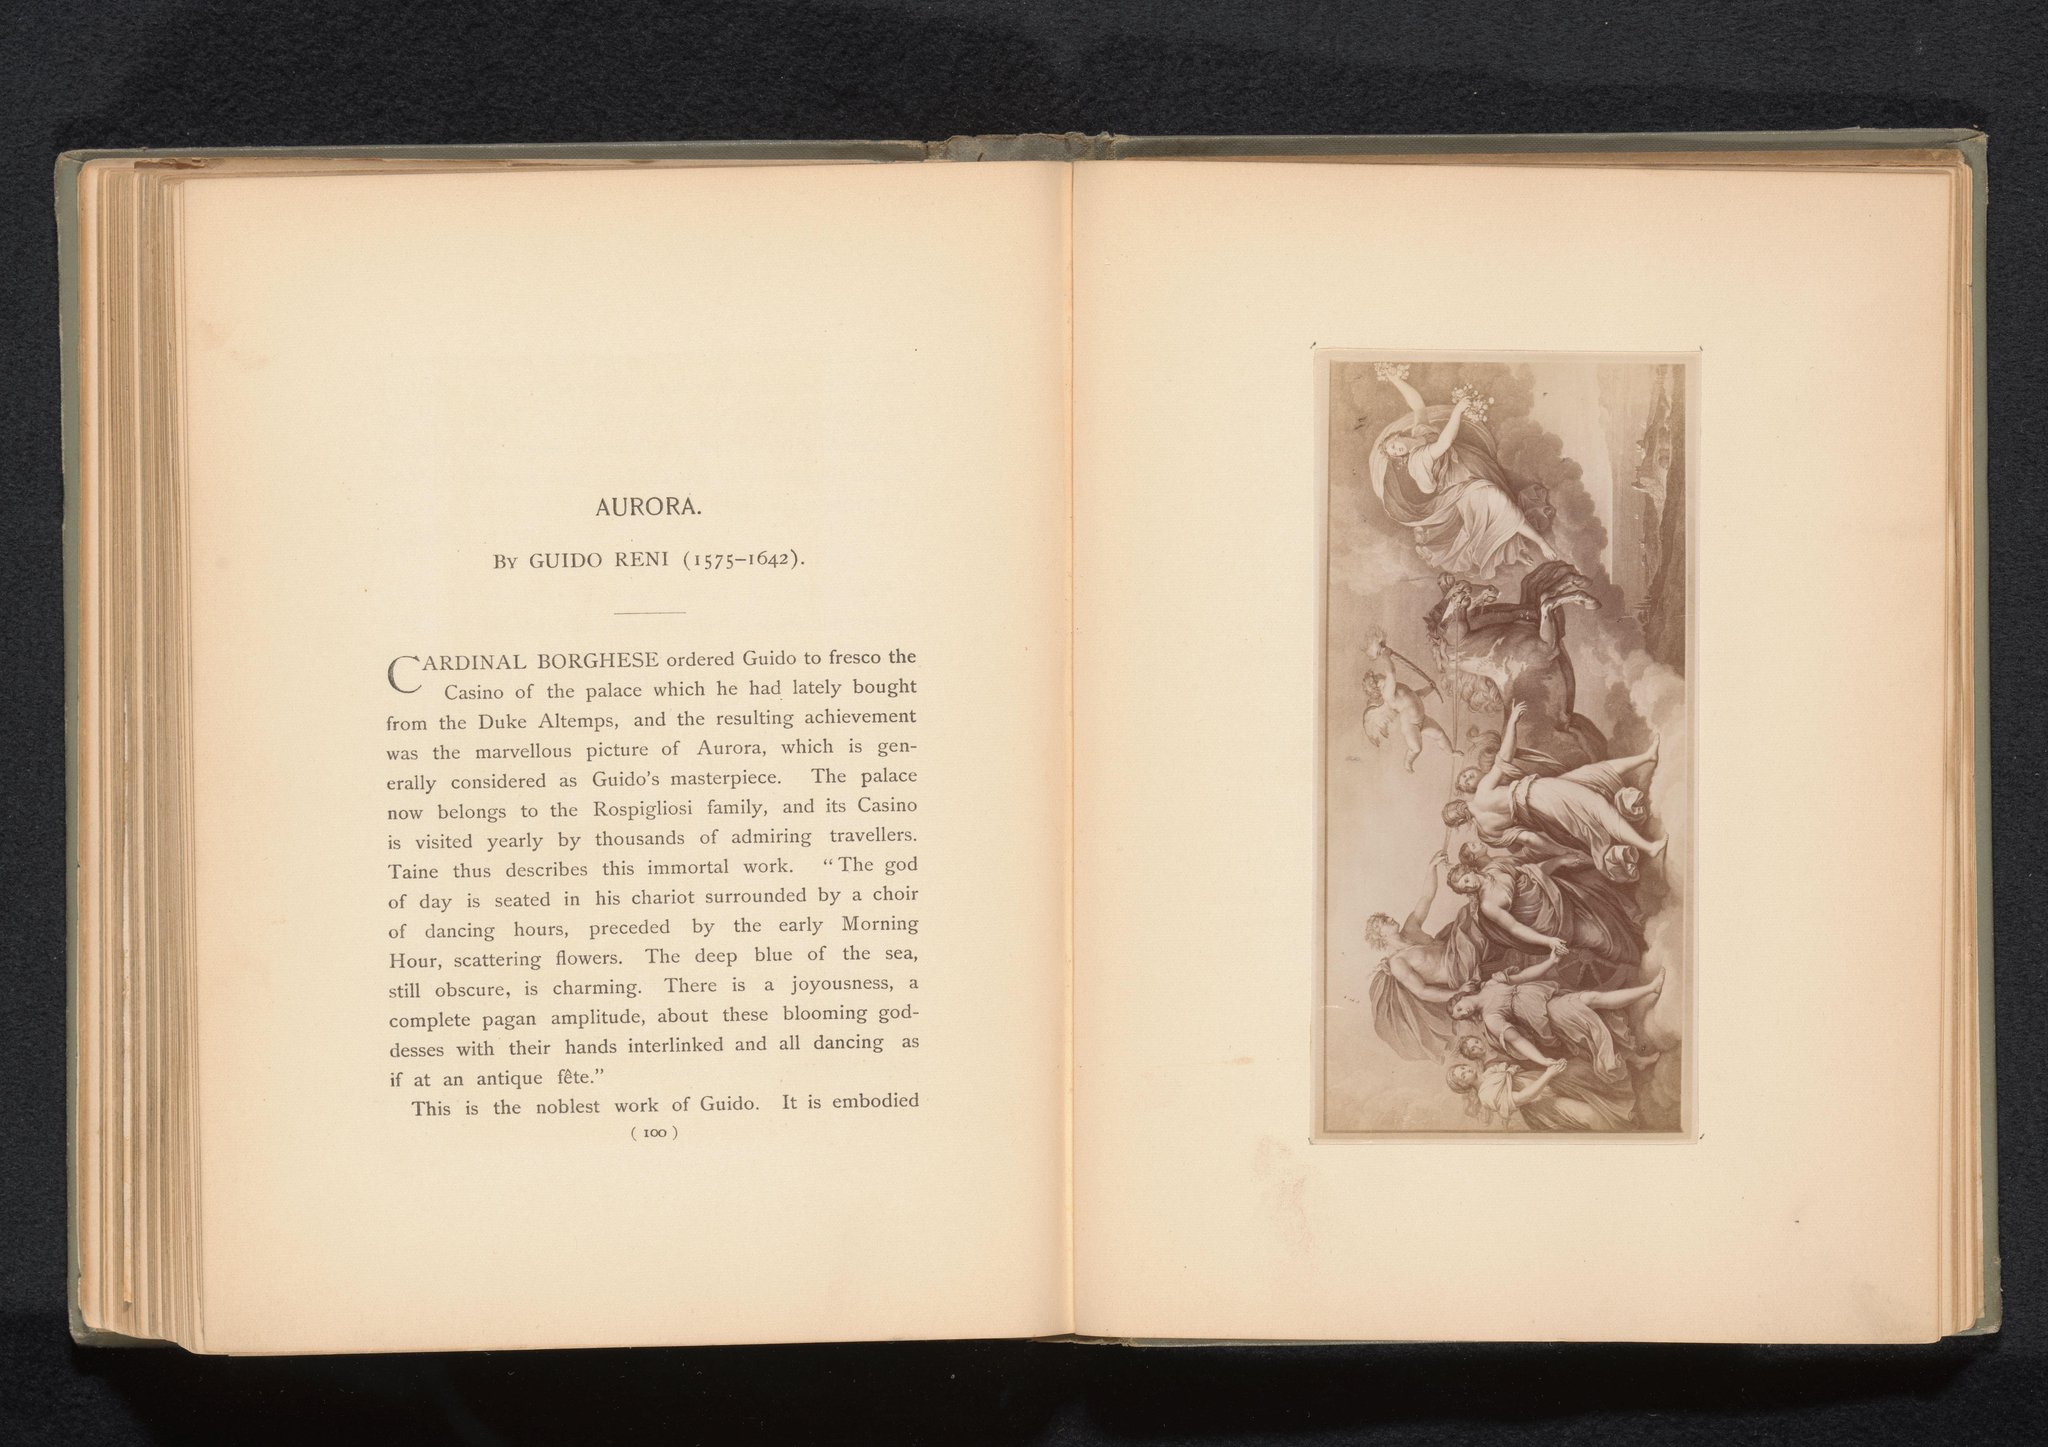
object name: reproduction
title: Fotoreproductie van een prent naar een schilderij, voorstellende de Dageraad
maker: Anonymous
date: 1882-1887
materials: photographic support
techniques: albumen print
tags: personification of the morning, 'aurora'; 'aurora' (ripa)